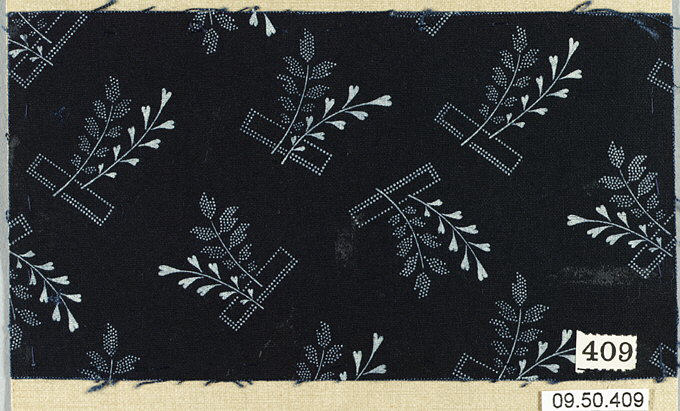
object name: piece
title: Piece (one of 116)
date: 1801-1900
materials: cotton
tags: leaves